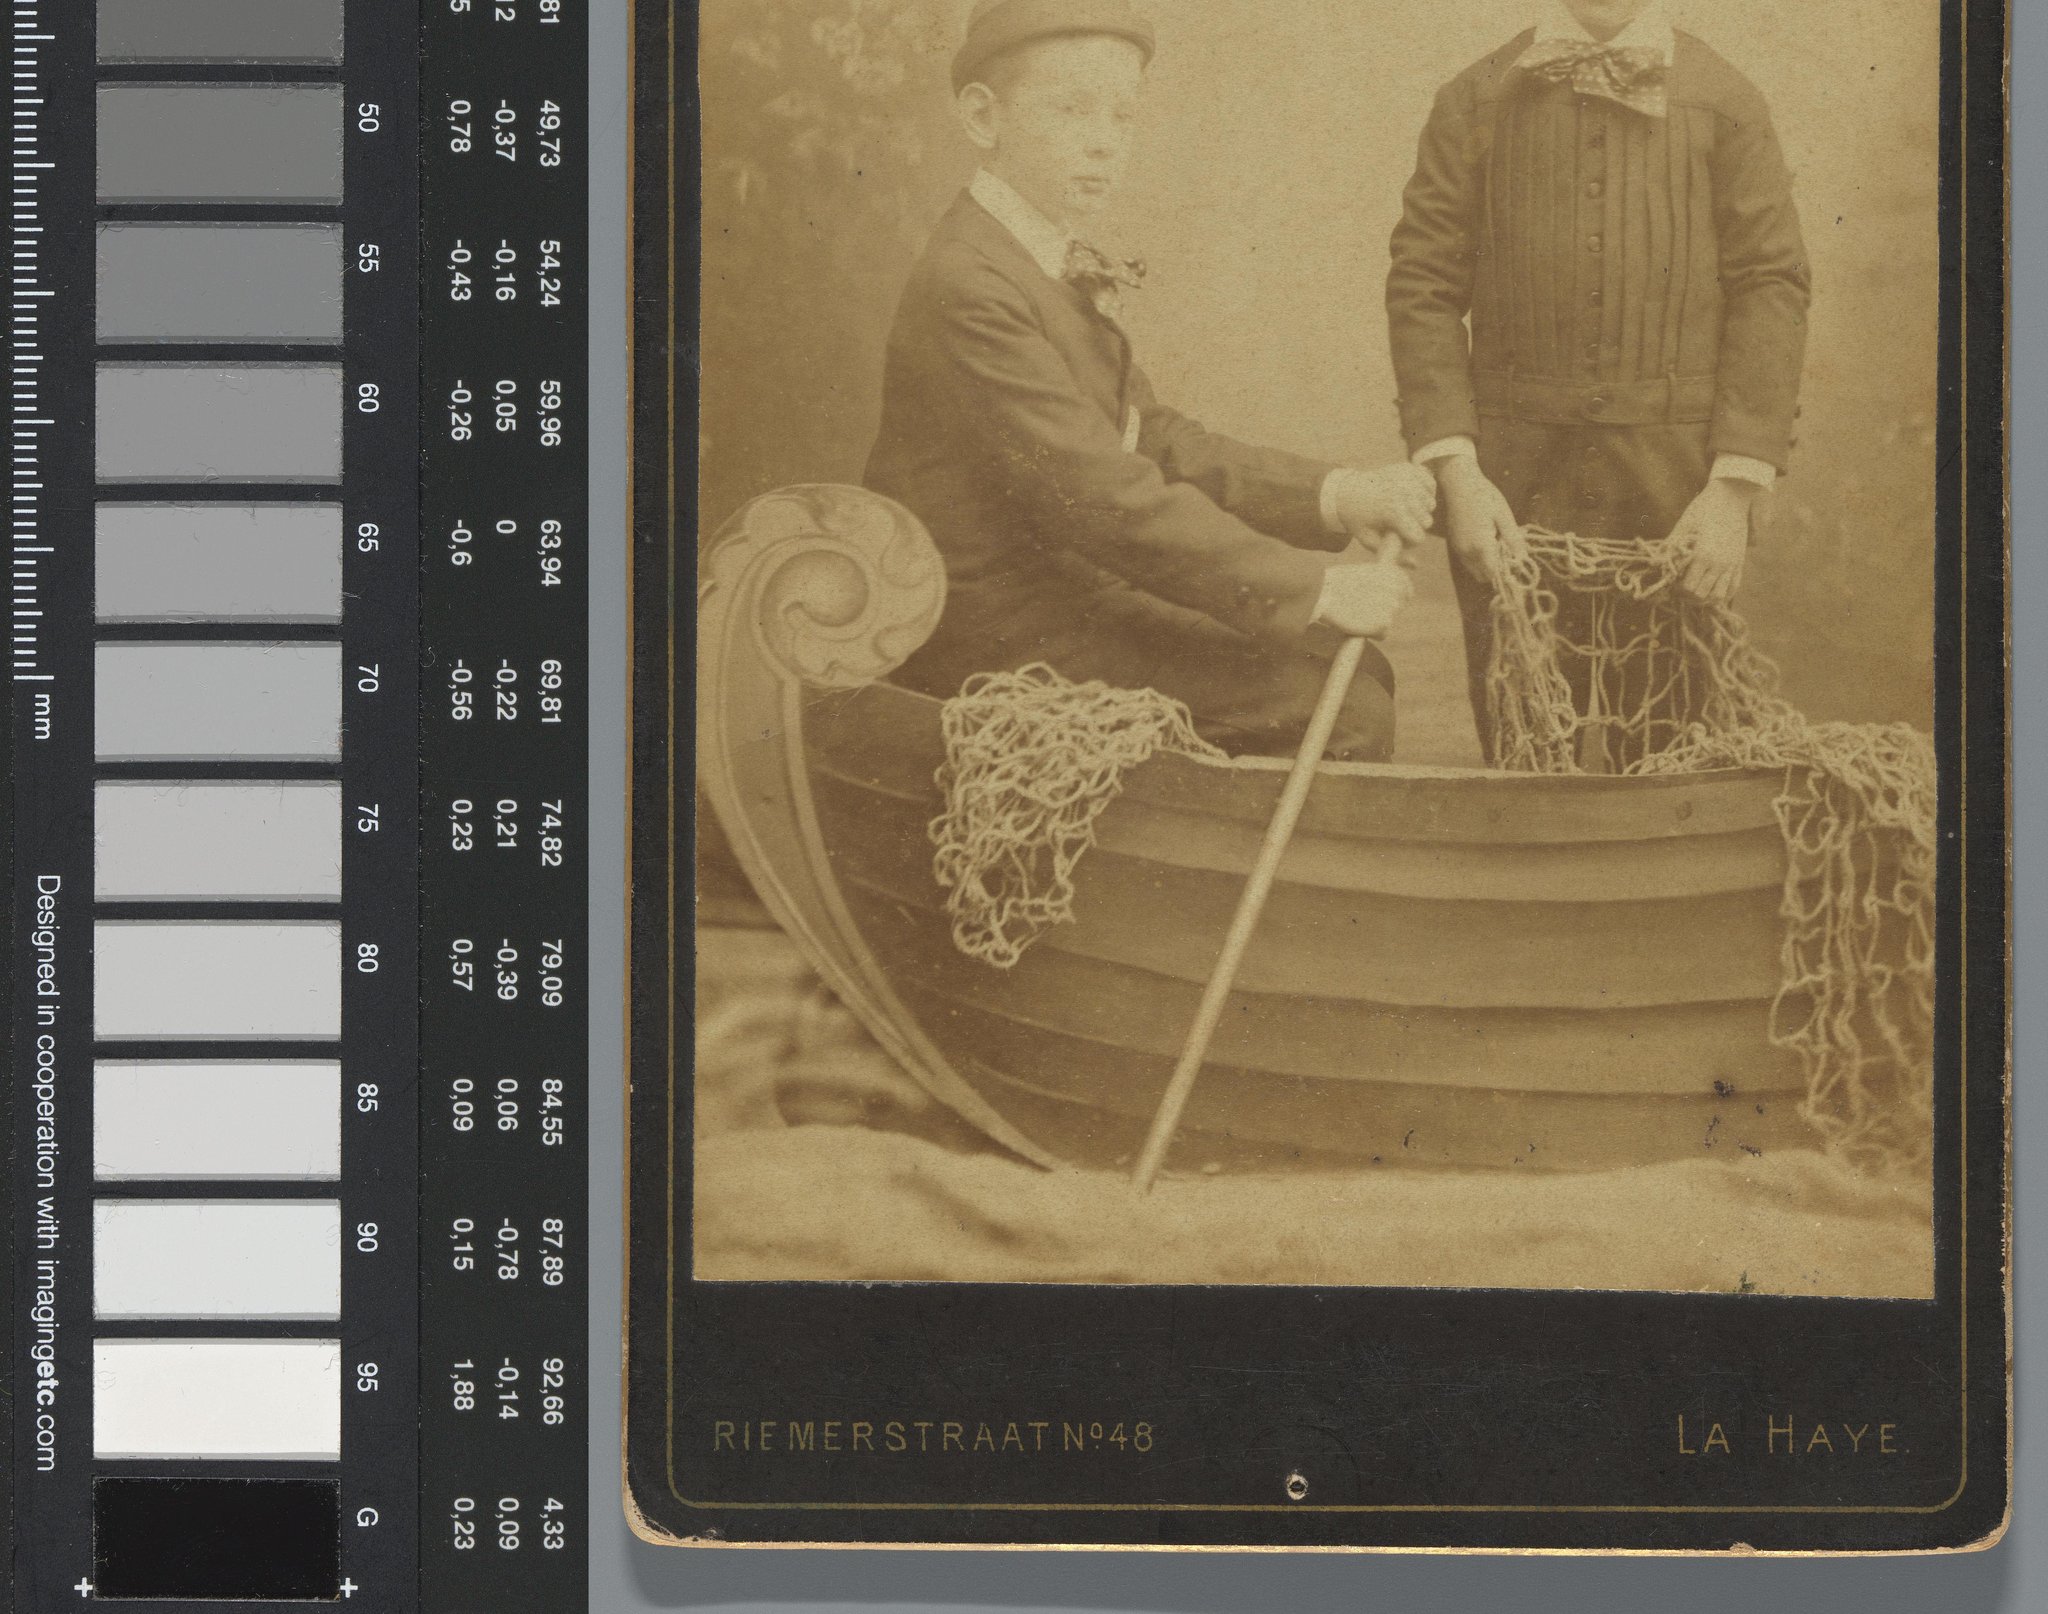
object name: cabinet photograph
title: Studioportret van twee jongens in een boot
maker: adolphe zimmermans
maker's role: fotograaf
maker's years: 1858-1922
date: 1882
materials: cardboard, photographic support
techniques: albumen print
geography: the hague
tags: batavia, karel frederik van den berg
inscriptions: name: ‘Oom Karel & vader / ± 1882’, inscription: ‘ADOLPHE / RIEMERSTRAAT No. 48 LA HAYE’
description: Studioportret van twee jongens in een boot. Karel van den Berg zit en naast hem staat een andere jongen met netten in zijn handen.